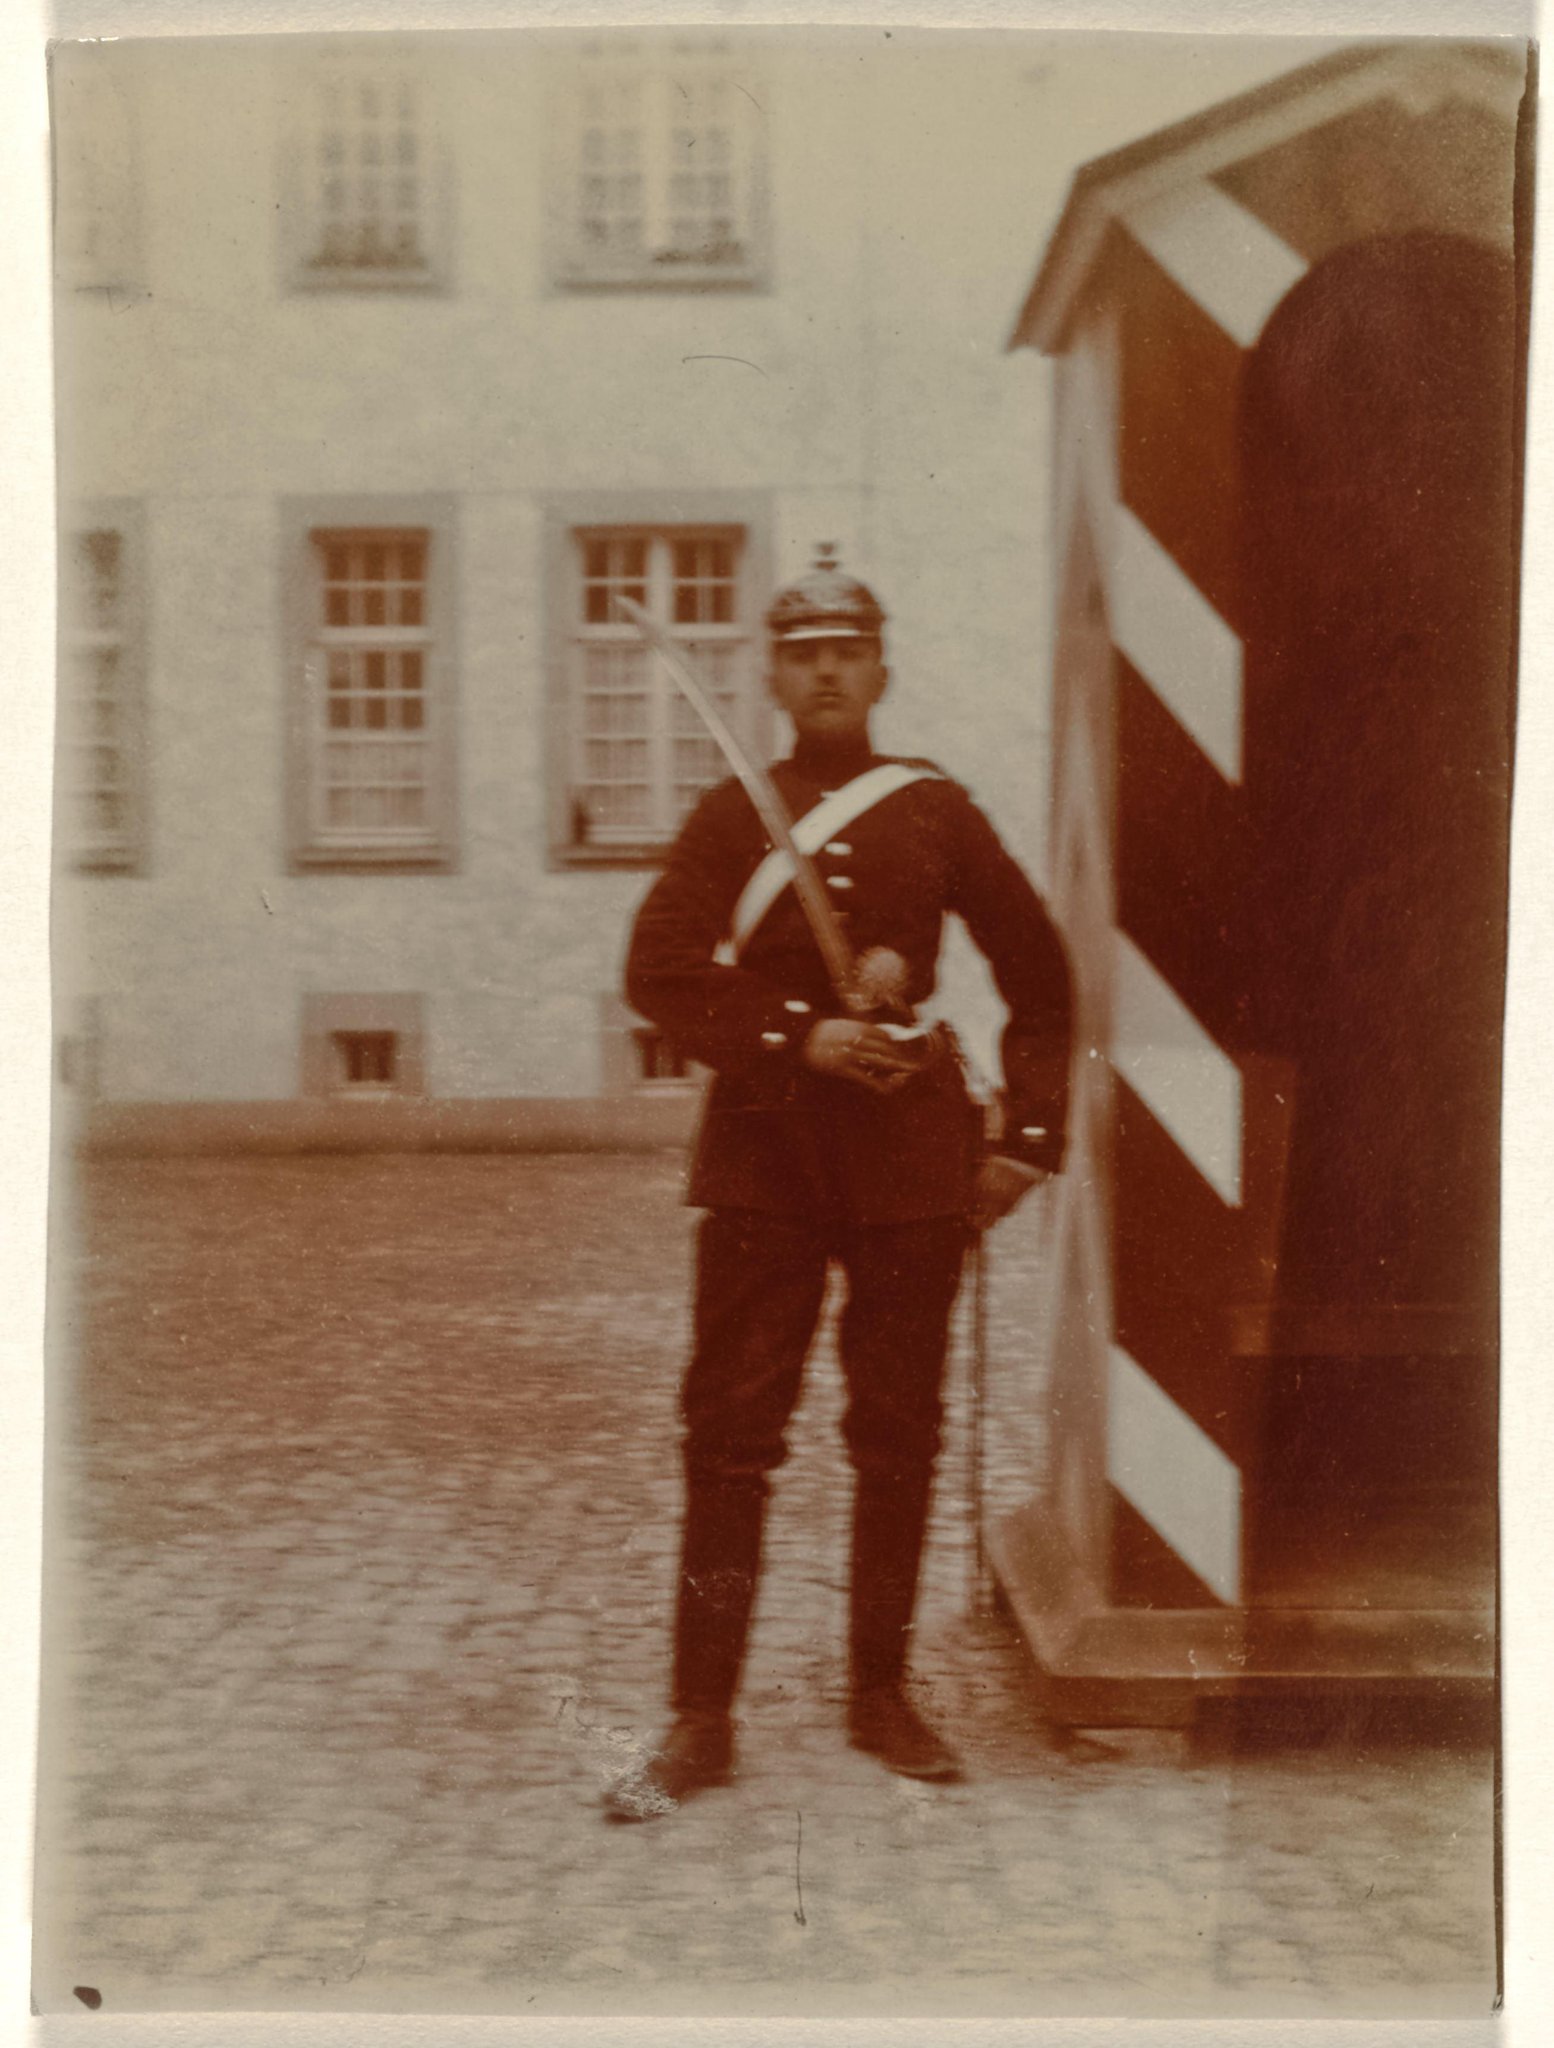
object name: photograph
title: Neef van de familie Wachenheimer als korporaal (Gefreiter) met sabel en Pickelhaube tijdens kazernewacht voor een wachthuisje, een april 1910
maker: Anonymous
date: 1910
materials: photographic support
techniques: gelatin silver print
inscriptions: inscription: ‘Dein vetter (onduidelijk geschreven) als Gefreiter auf Kasernewache am 1.4.1910.’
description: Neef van de familie Wachenheimer als korporaal met sabel en Pickelhaube tijdens kazernewacht voor een wachthuisje.